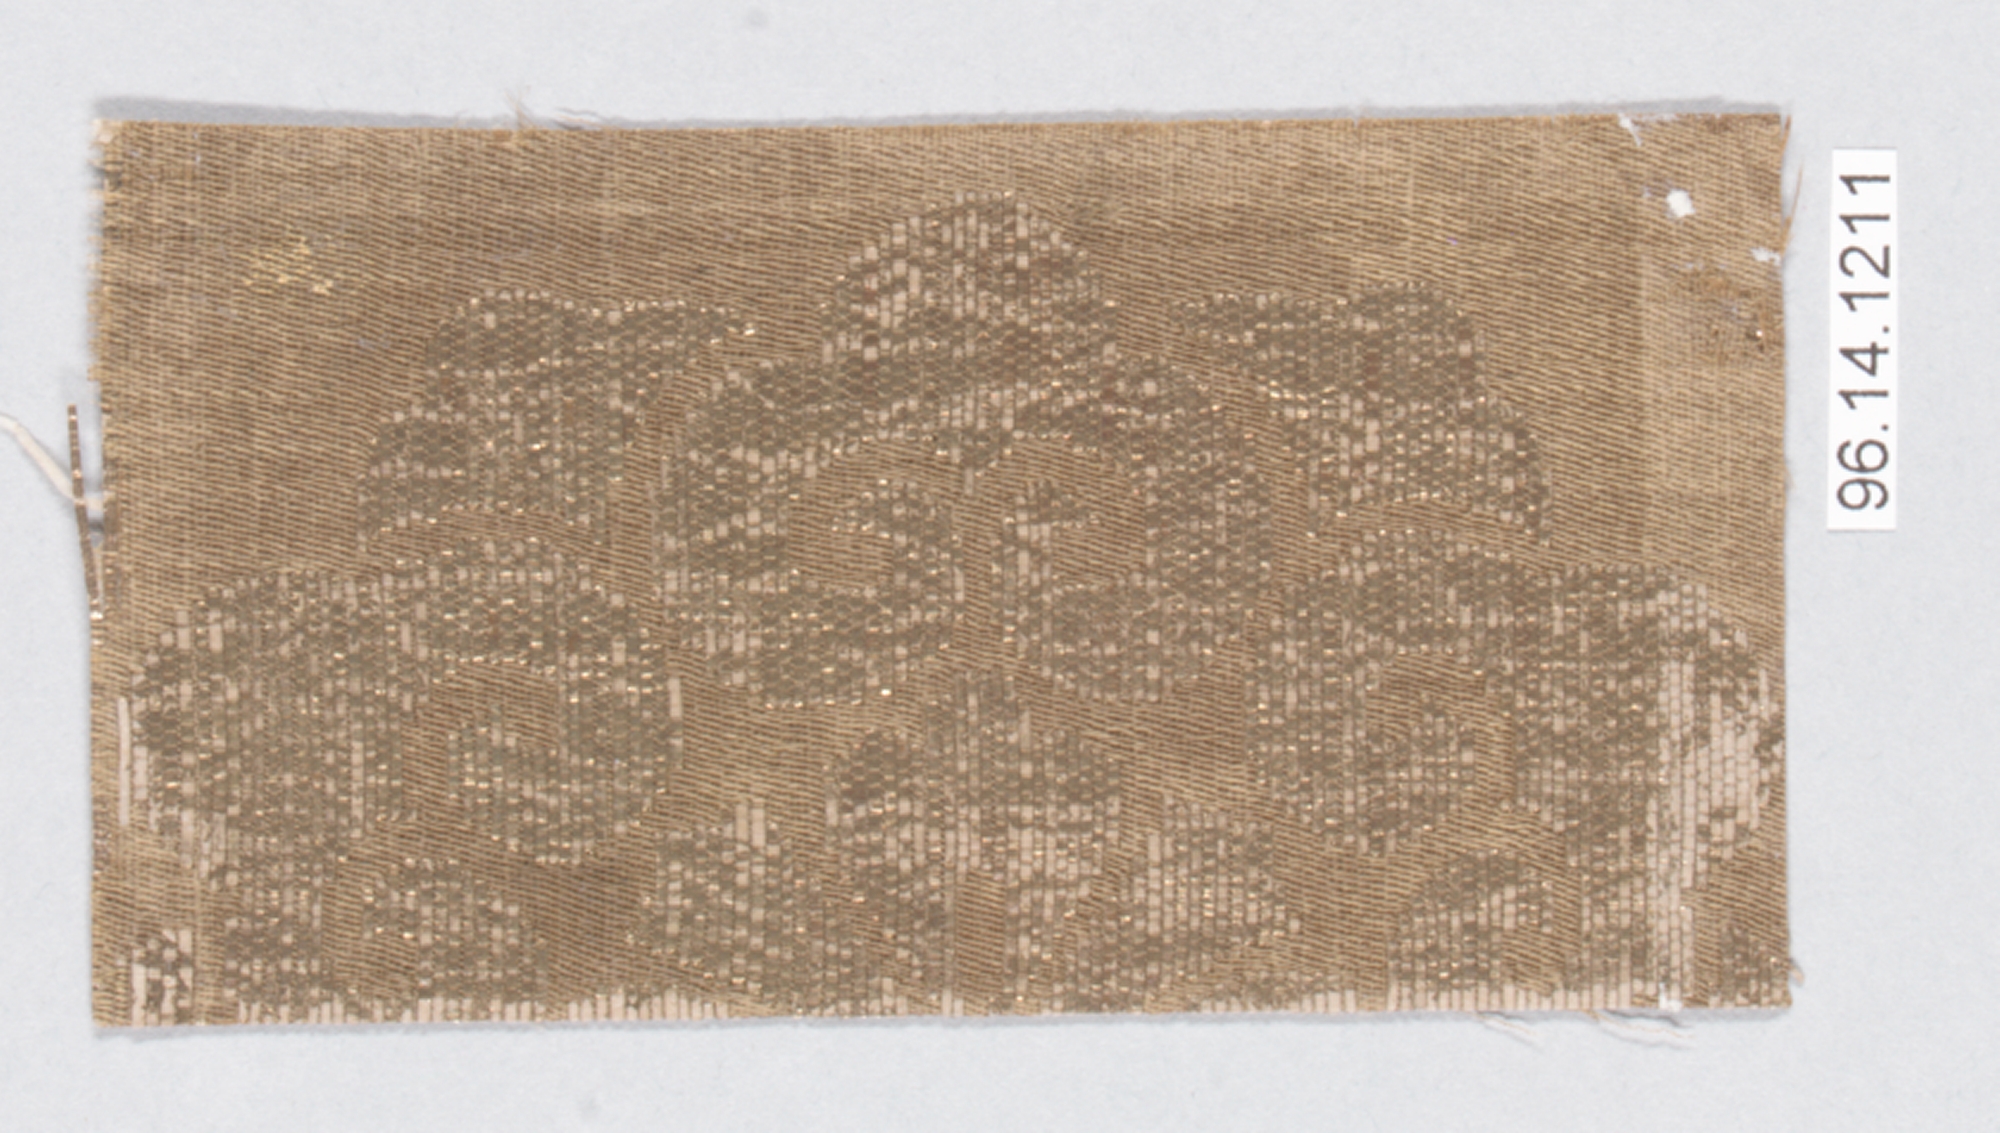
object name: piece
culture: japanese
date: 1801-1900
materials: metal thread, silk